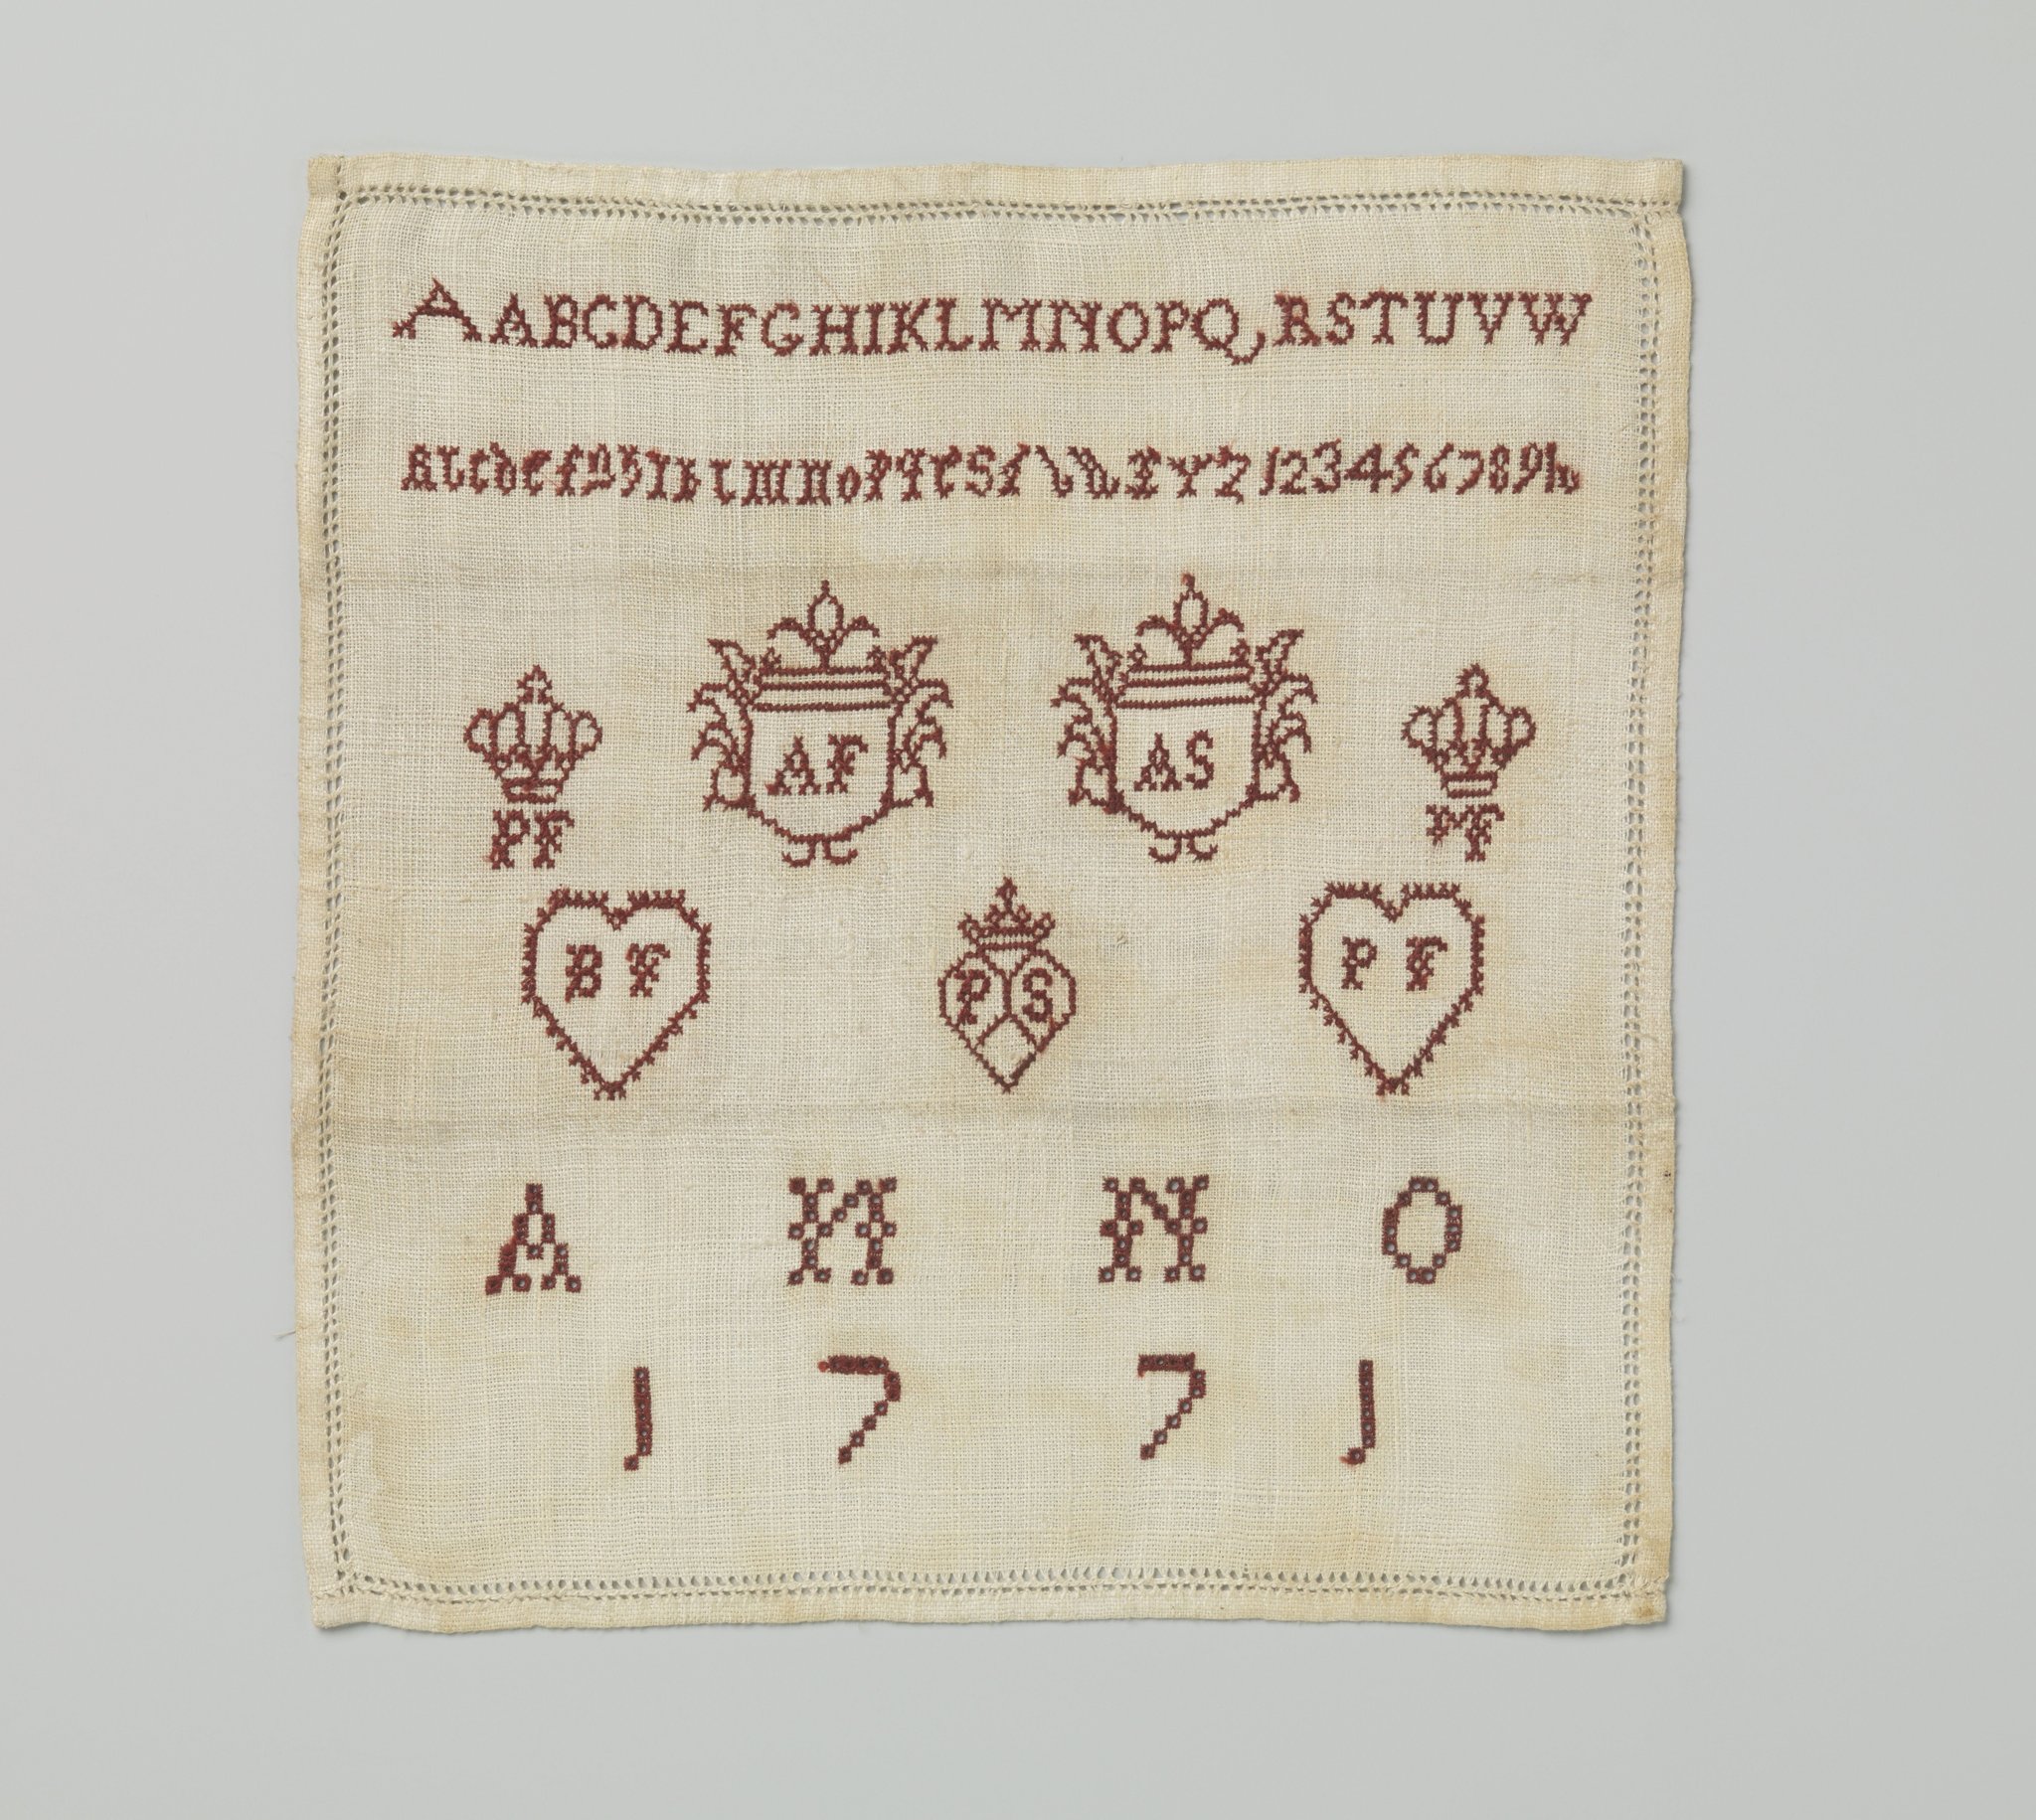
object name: merkdoek, merklap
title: Merklap van linnen waarop met zijde twee alfabetten (drukletters, gotisch), een cijferreeks, drie schilden, twee kronen en twee harten met initialen en ANNO 1771 is geborduurd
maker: Anonymous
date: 1771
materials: linen, silk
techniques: embroidered, weave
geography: dutch reformed diaconie orphanage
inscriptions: date: ‘ANNO/ 1771’, initials: ‘AF, AS/ PF, FF/ BF, PS, PF’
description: Dit type merklappen diende als leermiddel voor het merken van servetten en zakdoeken, die aan beide zijden werden gebruikt en waarbij geen af- en aanhechtingen zichtbaar moesten zijn. De cijfers 1 tot 9 en het getal 10 werden geoefend om het linnengoed te kunnen nummeren. Het gebruik van de letter Q in het alfabet is vroeg voor 1771. De initialen, kronen en harten werden de weesmeisjes geleerd voor opdrachten van buiten. De initialen PS zijn mogelijk van het meisje. Eerst open zoom gemaakt, daarna echt gezoomd.